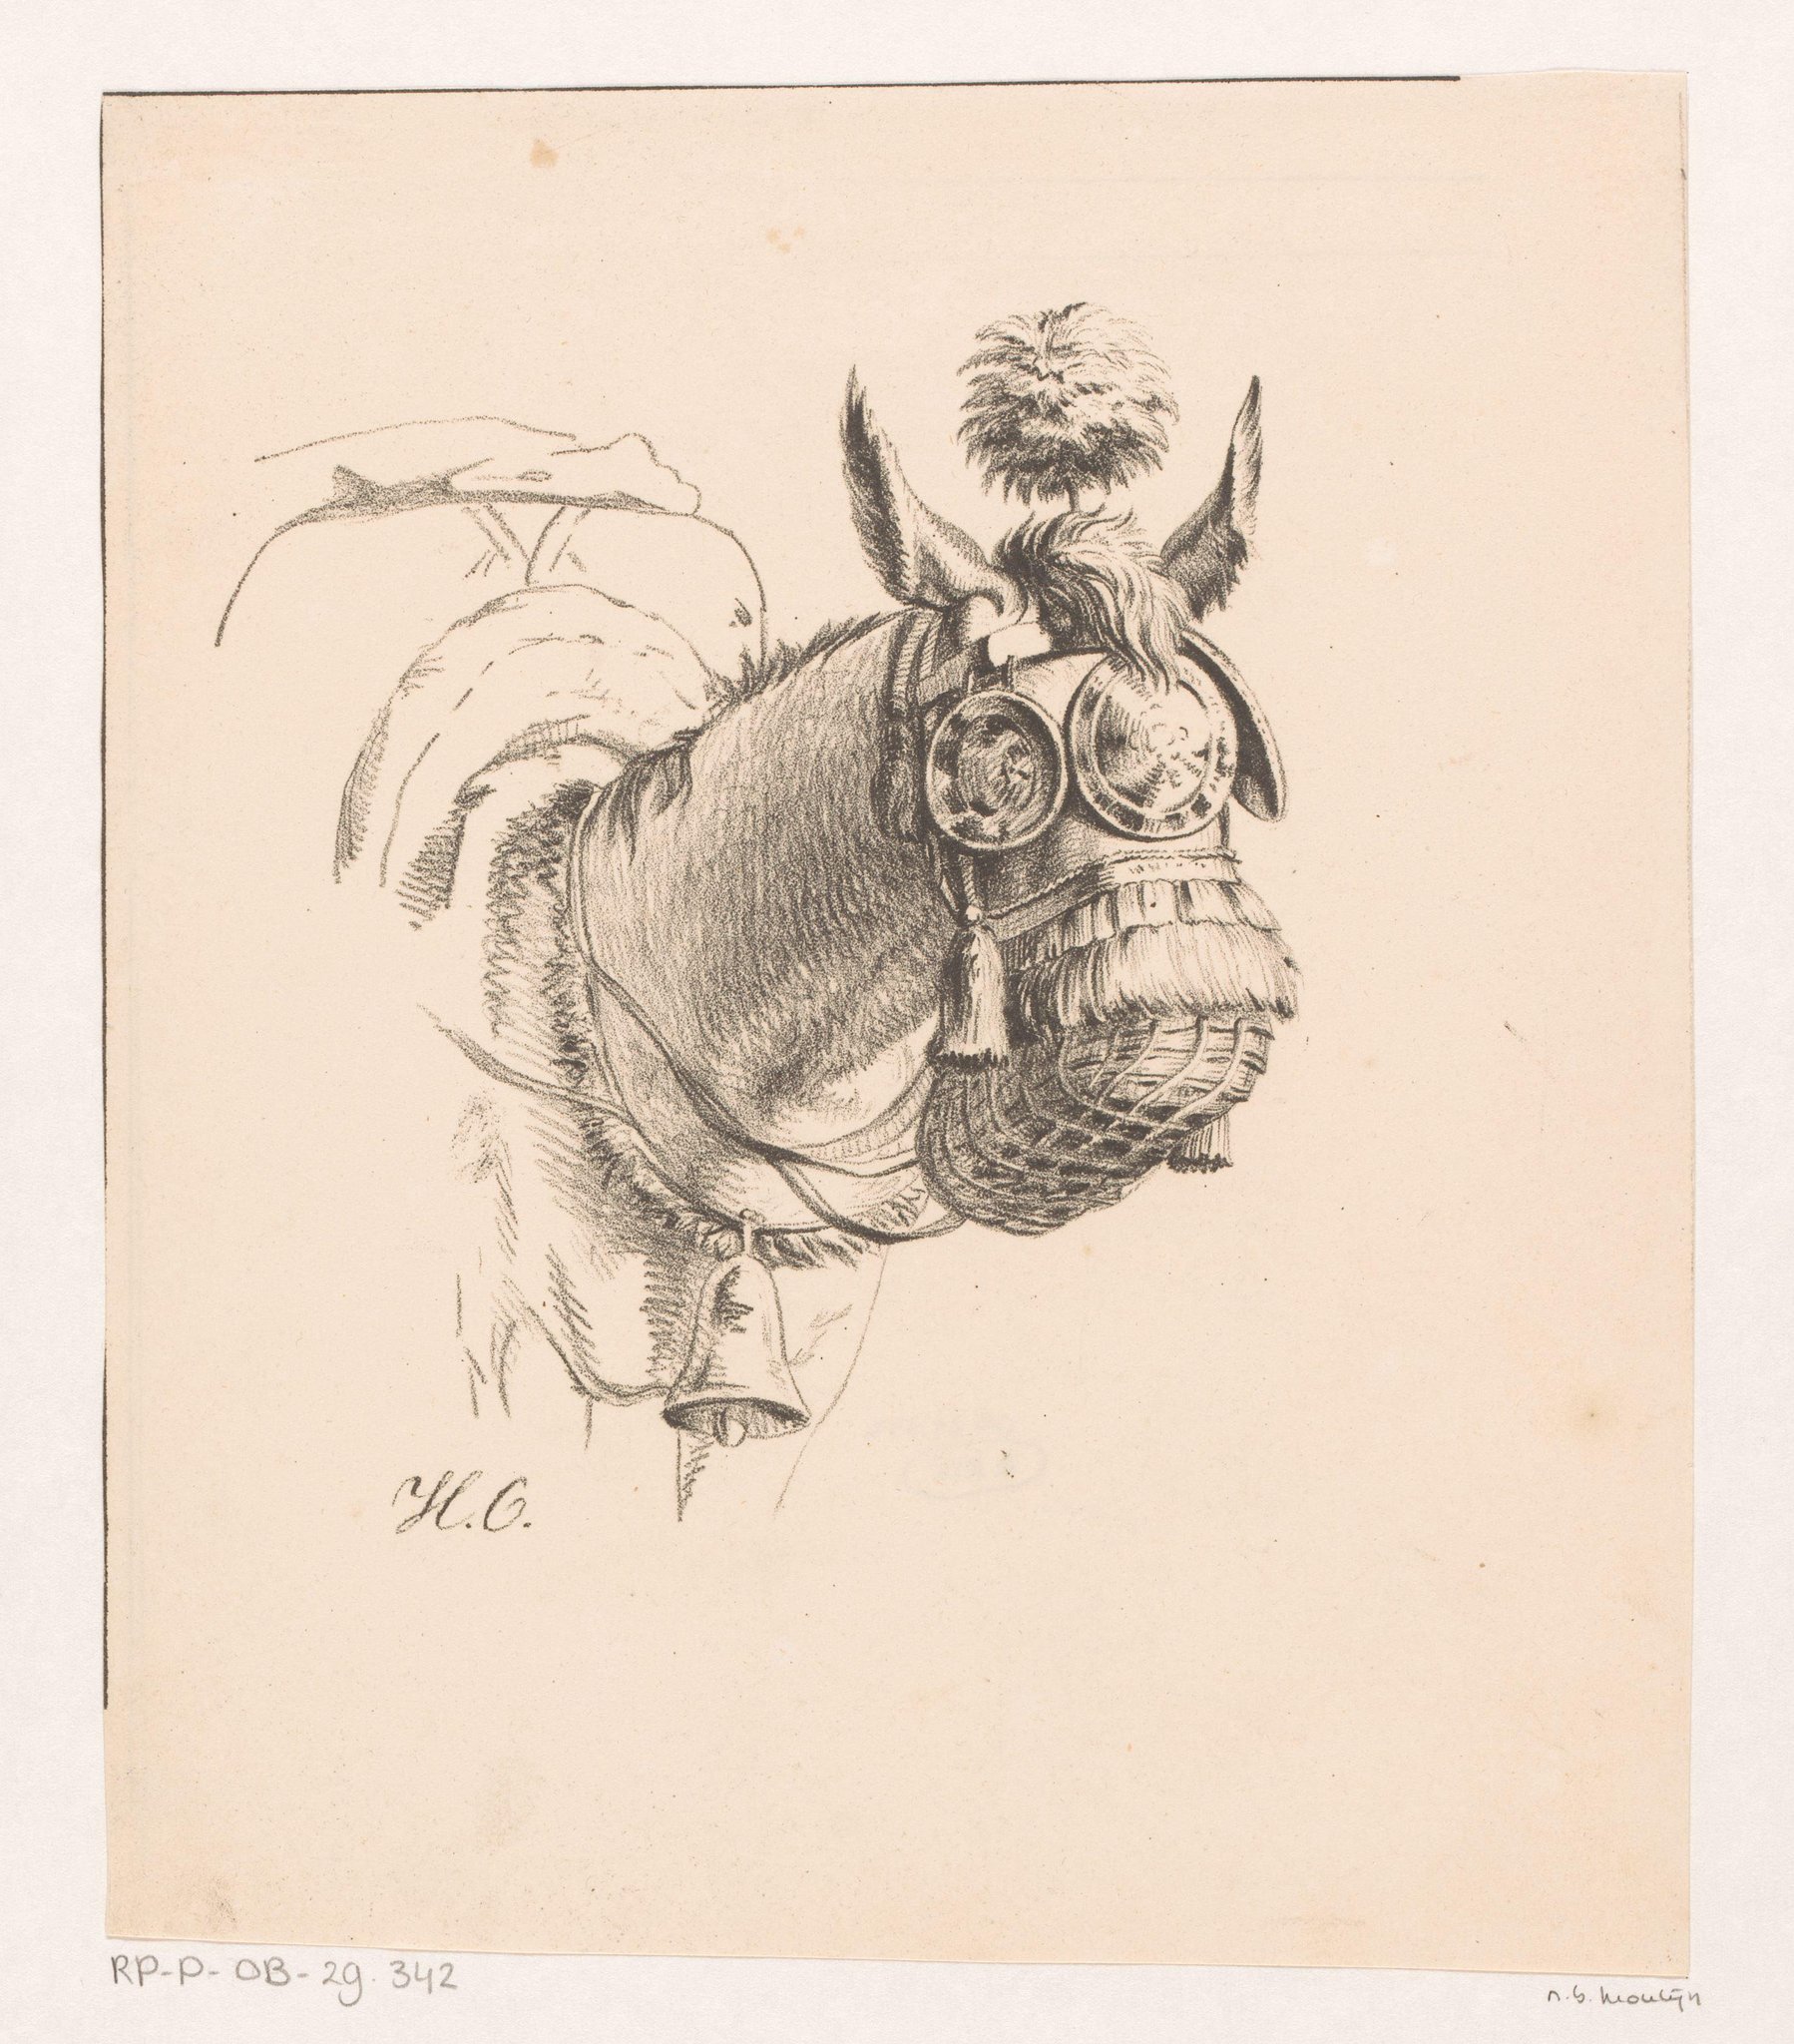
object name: print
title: Paardenhoofd met halster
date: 1809-1872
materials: paper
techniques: lithograph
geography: netherlands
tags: head-stall, horse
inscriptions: collector's mark: Lugt 2228